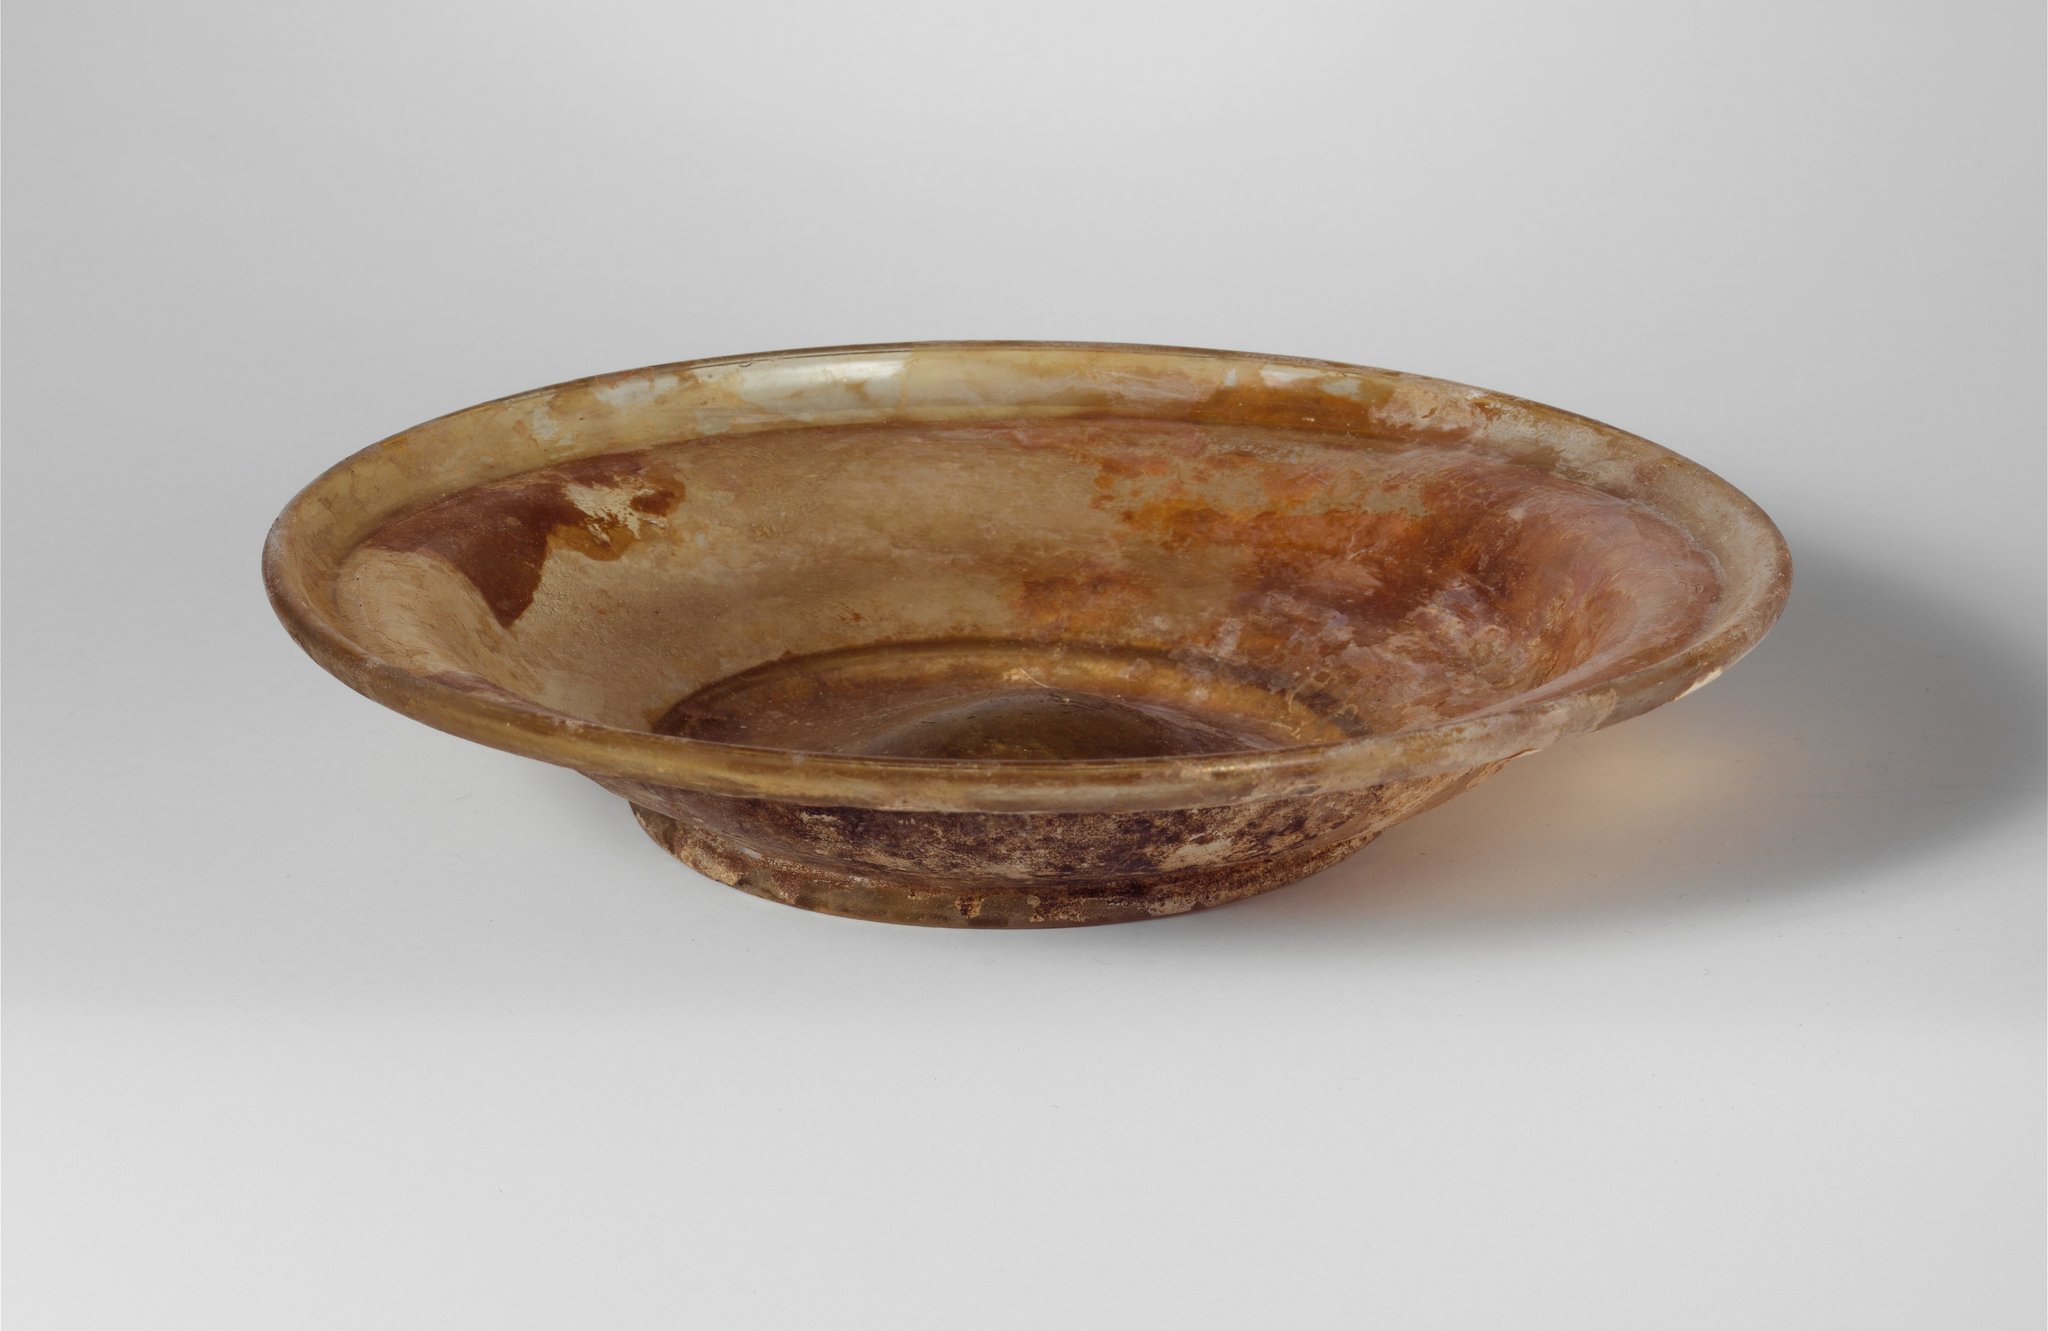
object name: dish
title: Glass dish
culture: roman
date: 301-400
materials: glass